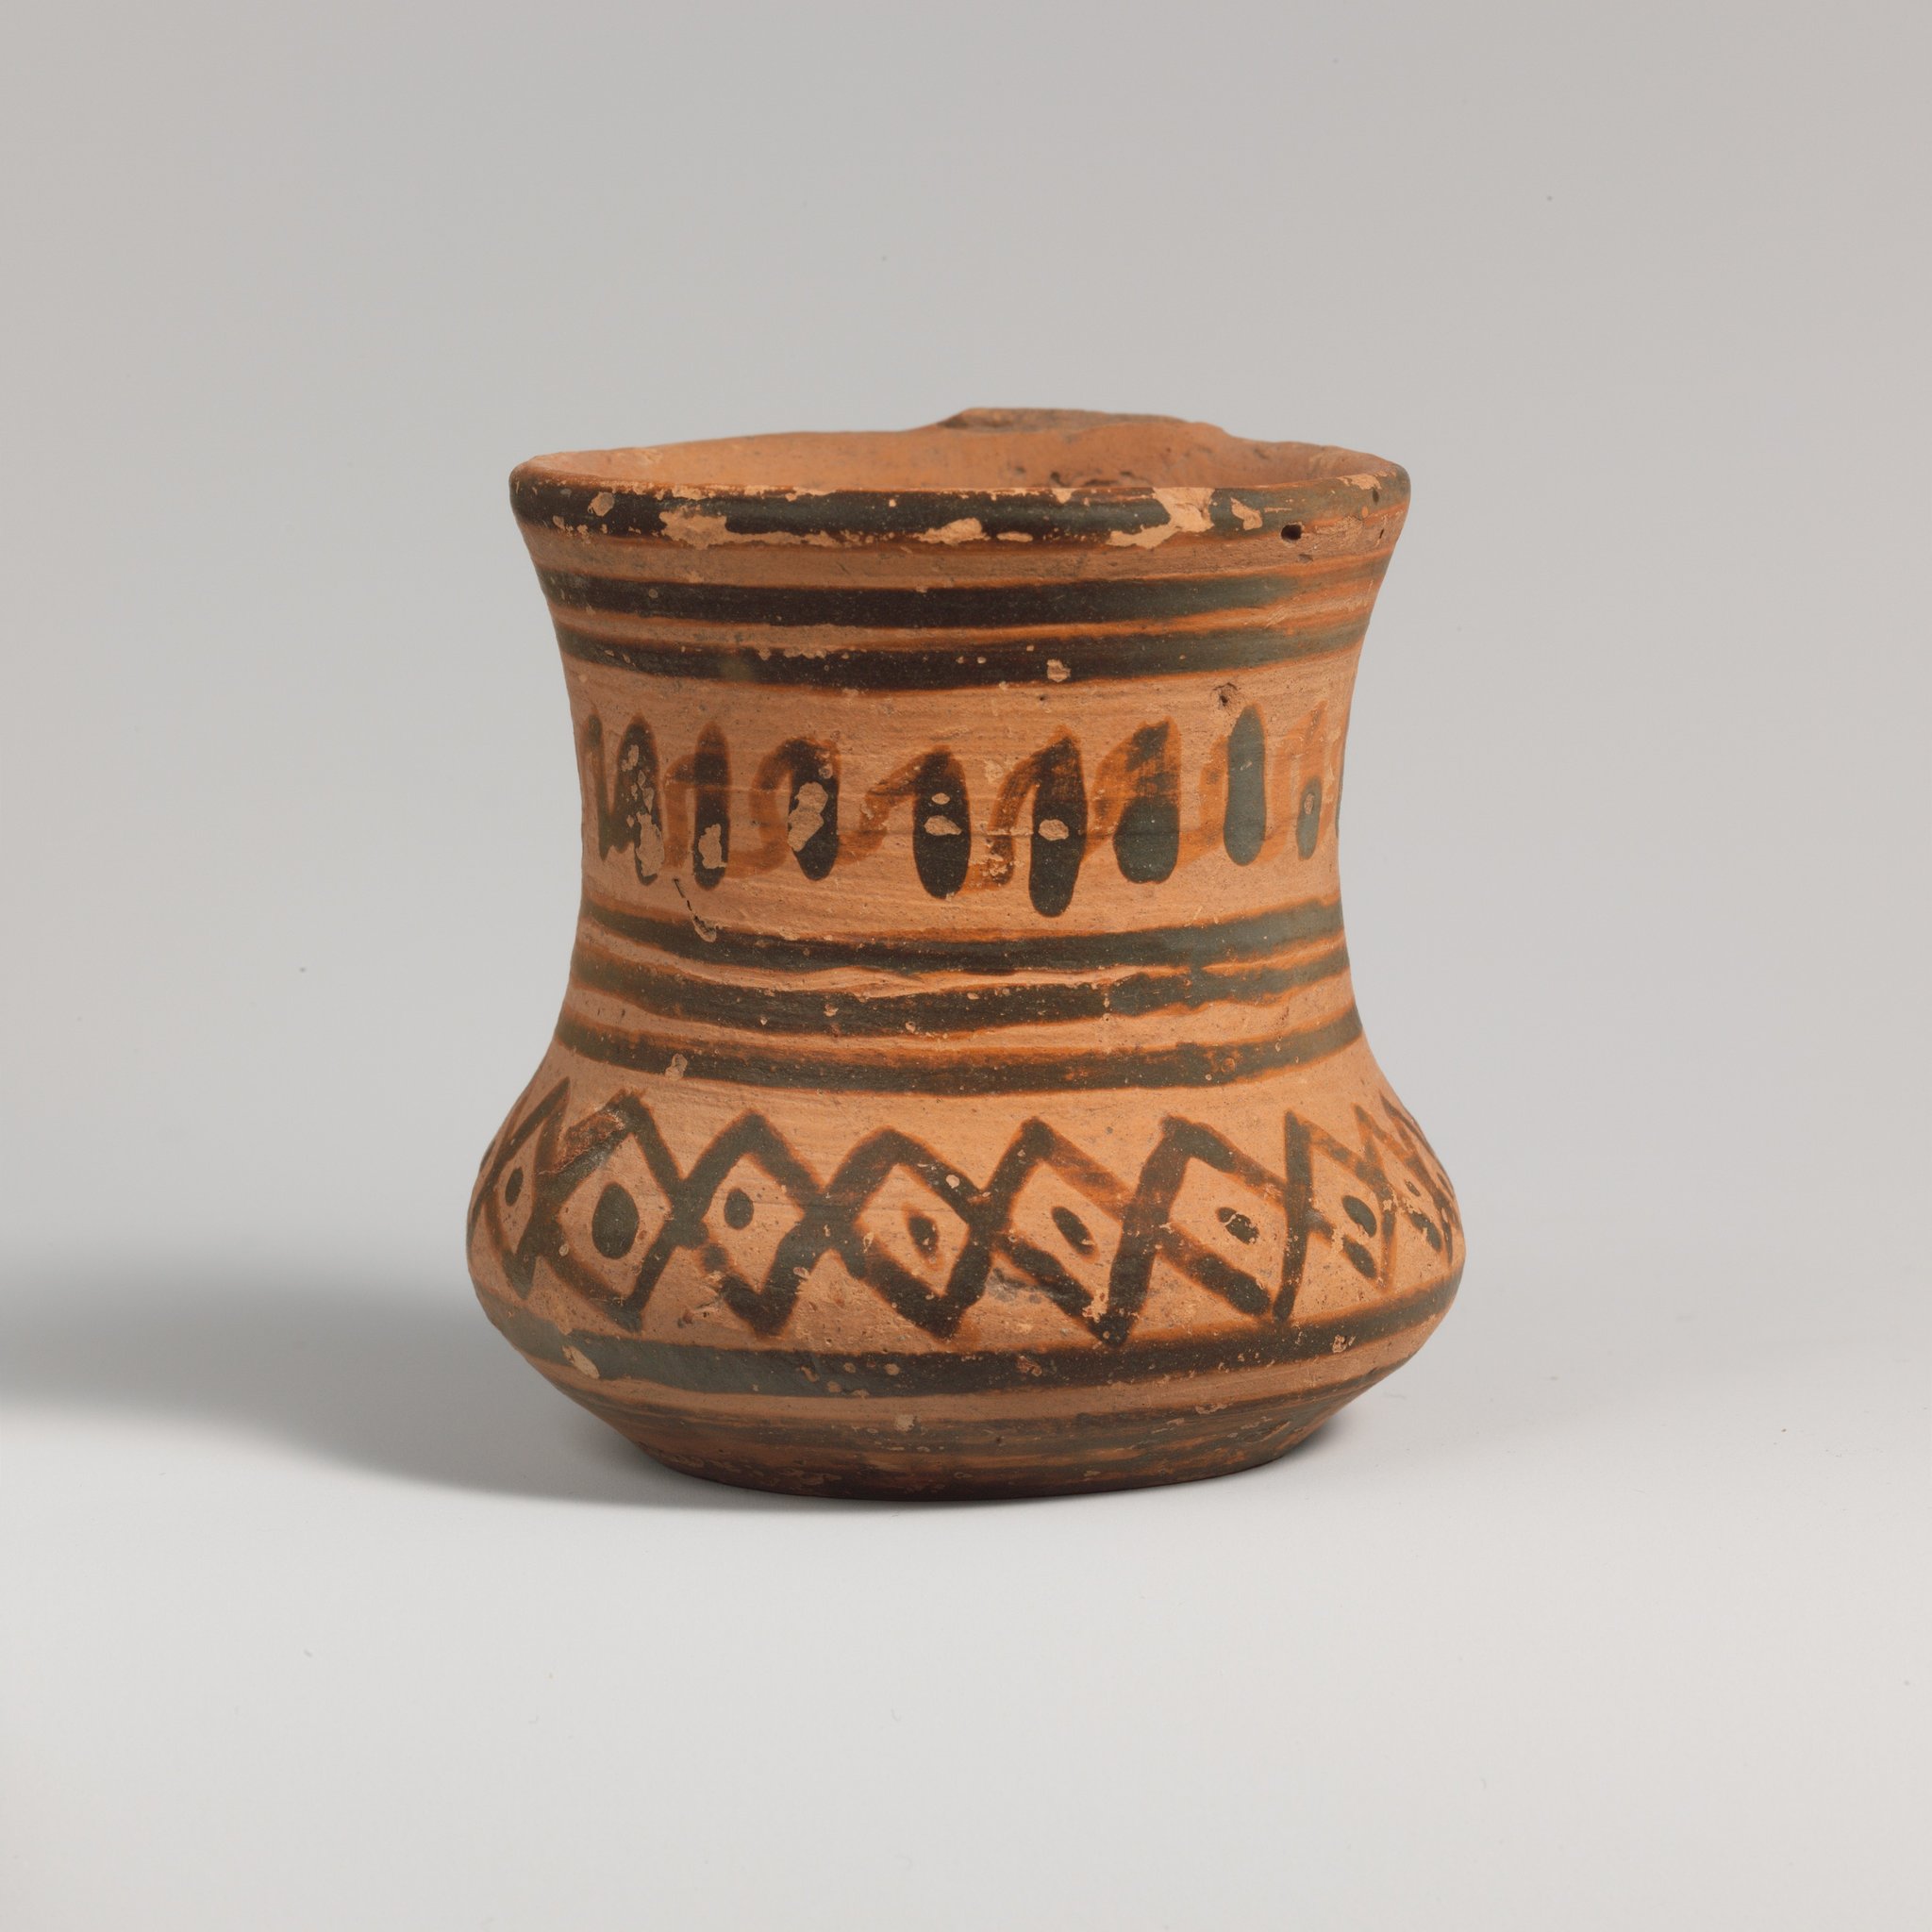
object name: tankard, miniature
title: Terracotta tankard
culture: greek, attic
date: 734-701 BCE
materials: terracotta